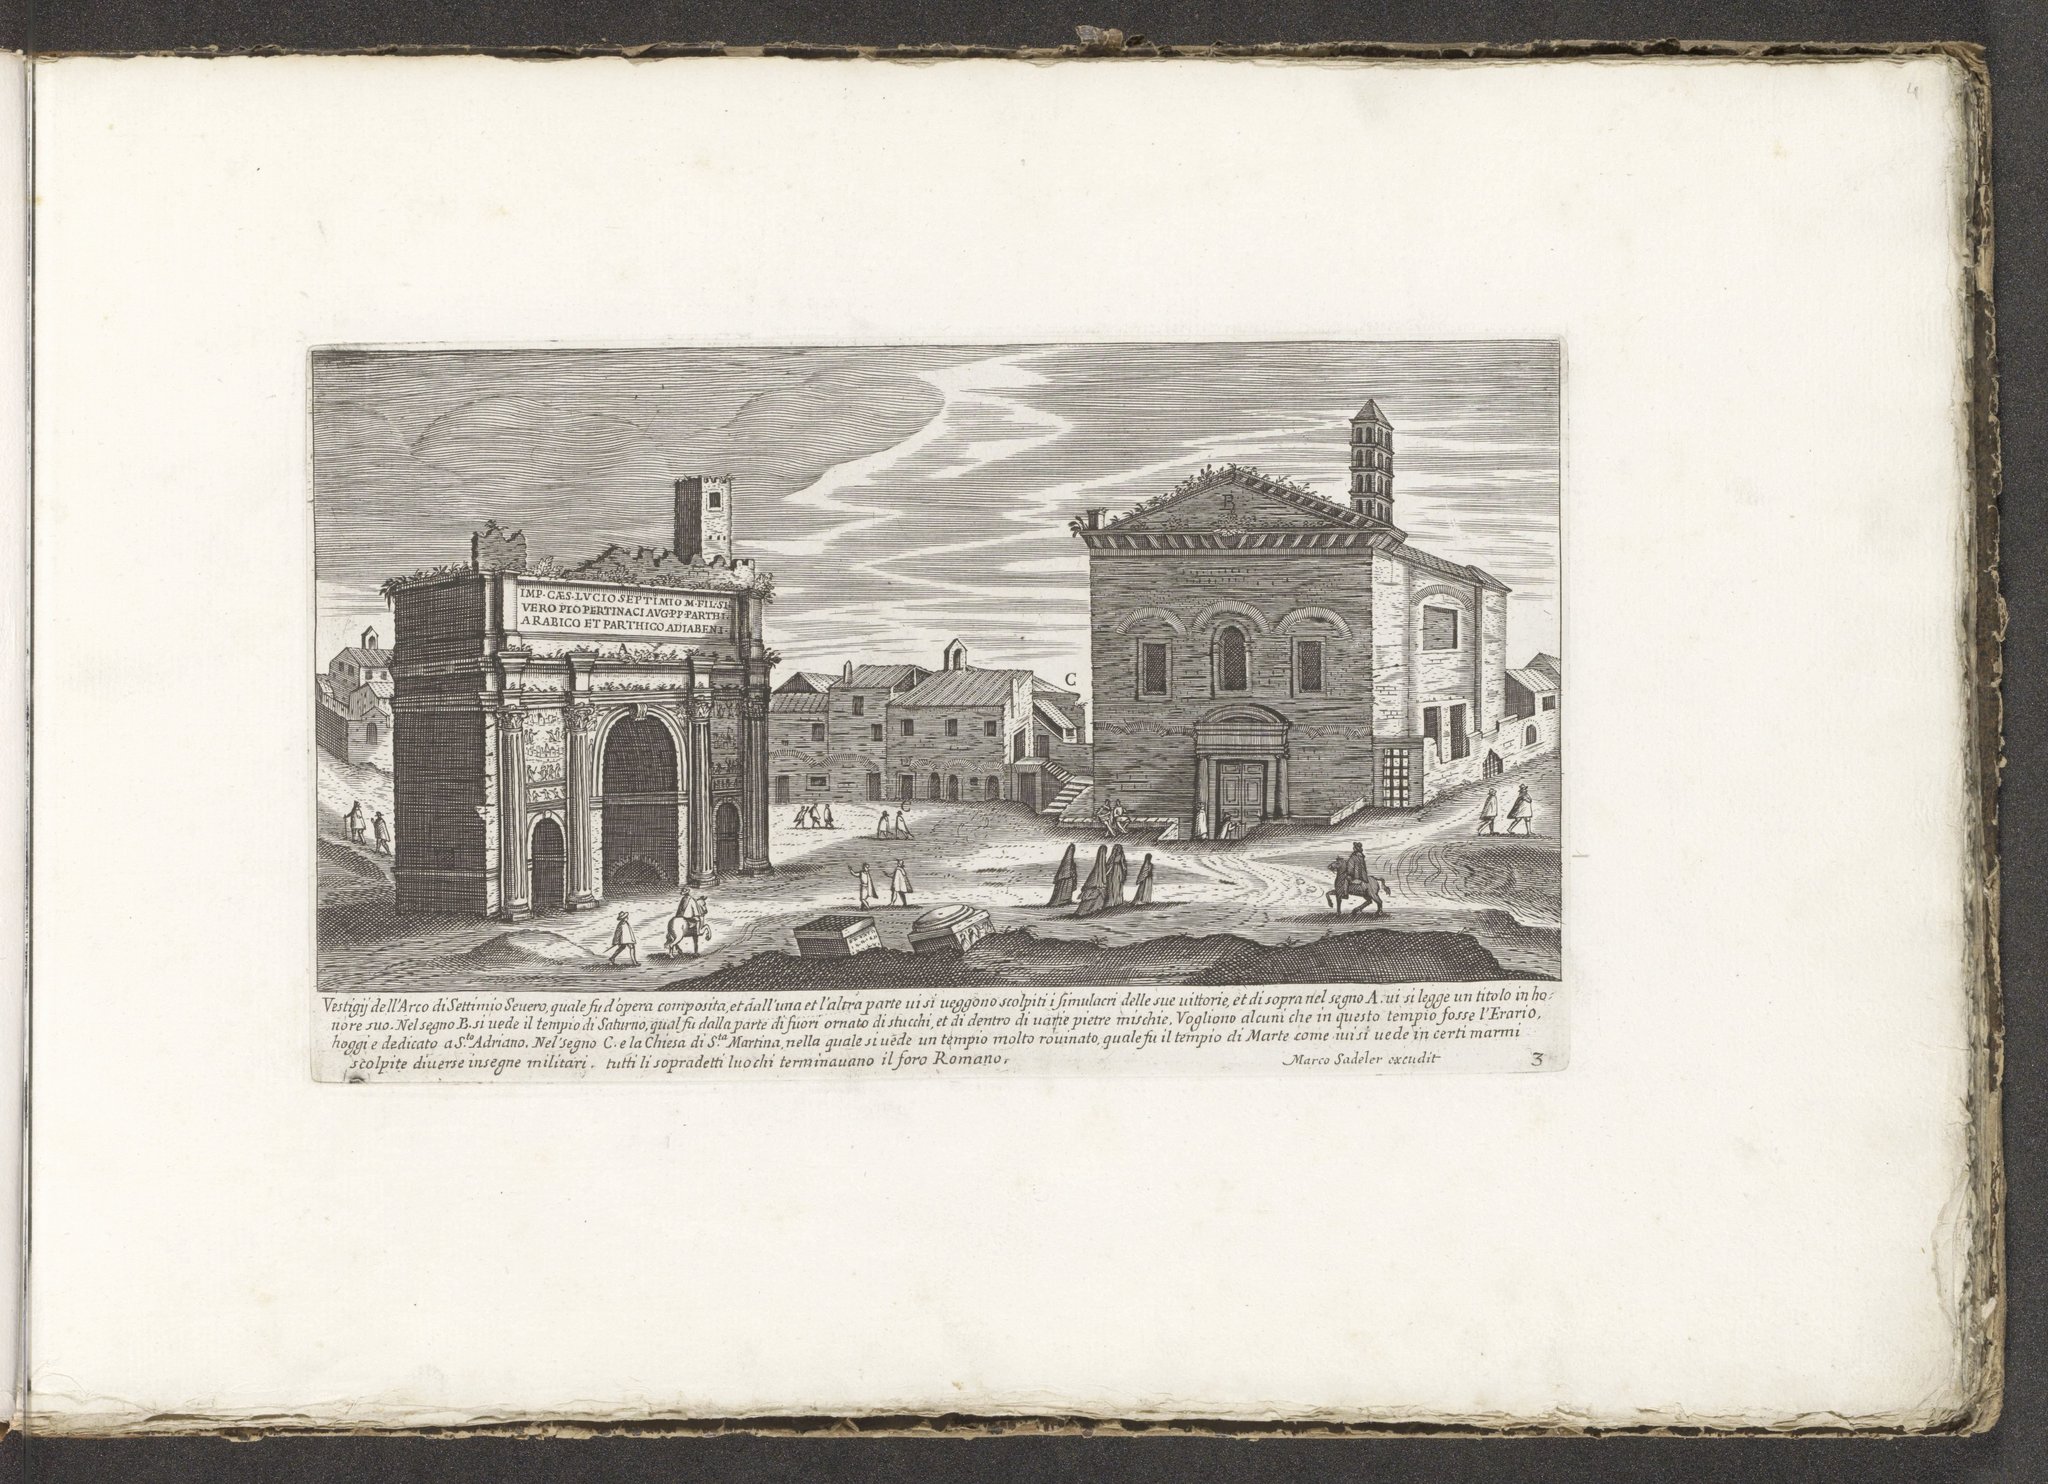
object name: album leaf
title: Vestigi delle antichita di Roma, Tivoli, Pozzuolo et altri luochi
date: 1680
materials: paper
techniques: engraving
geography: prague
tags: santi luca e martina, curia julia, forum romanum, boog van septimius severus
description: Aanzicht van het Forum Romanum met de Boog van Septimius Severus en de Curia Julia, hier ten onrechte de tempel van Saturnus genoemd. Daartussen de kerk gewijd aan de heilige Martina, waar nu de Santi Luca e Martina staat. In de ondermarge vier regels tekst in het Italiaans. De prent maakt deel uit van een album.